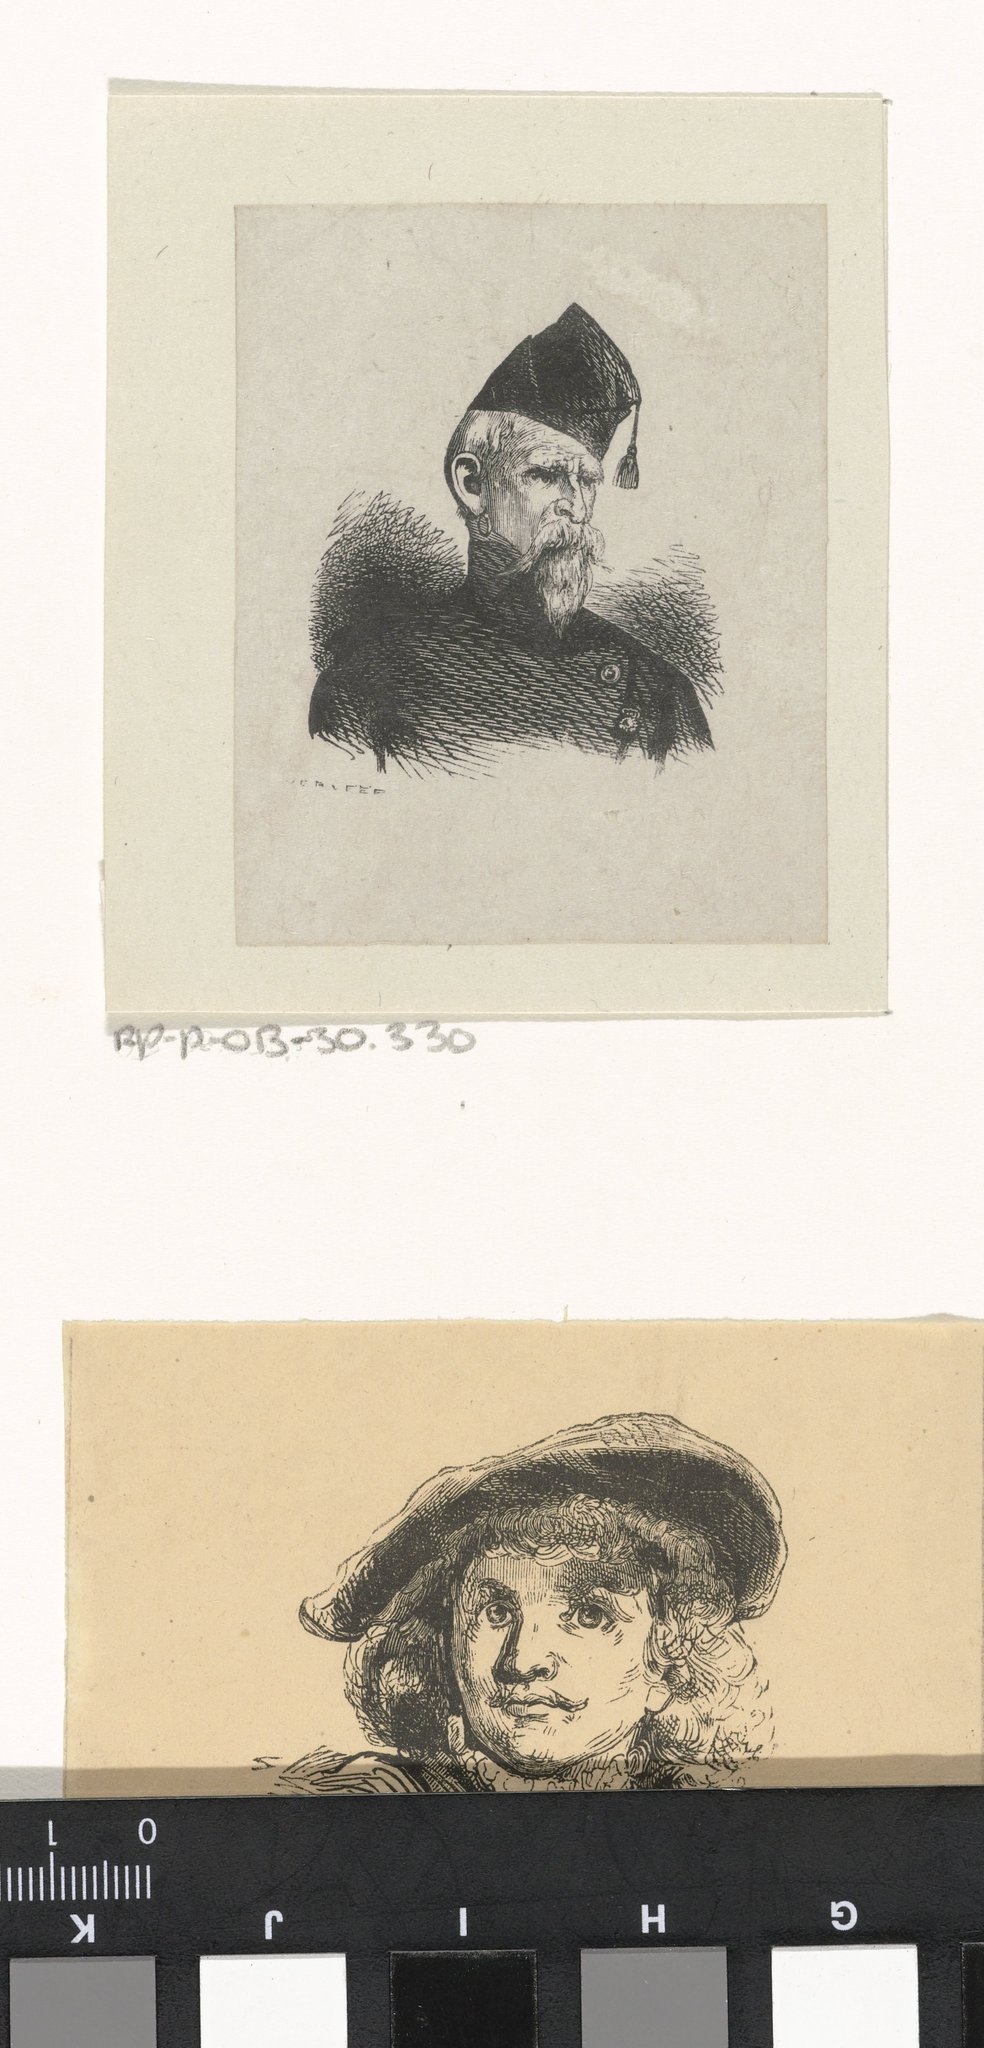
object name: print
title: Man met een muts en een oorring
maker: elchanon verveer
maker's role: draughtsman, print maker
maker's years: 1826-1900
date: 1836-1900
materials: paper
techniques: engraving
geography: the hague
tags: head-gear: cap (+ men's clothes), ear-rings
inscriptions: collector's mark: Lugt 2228